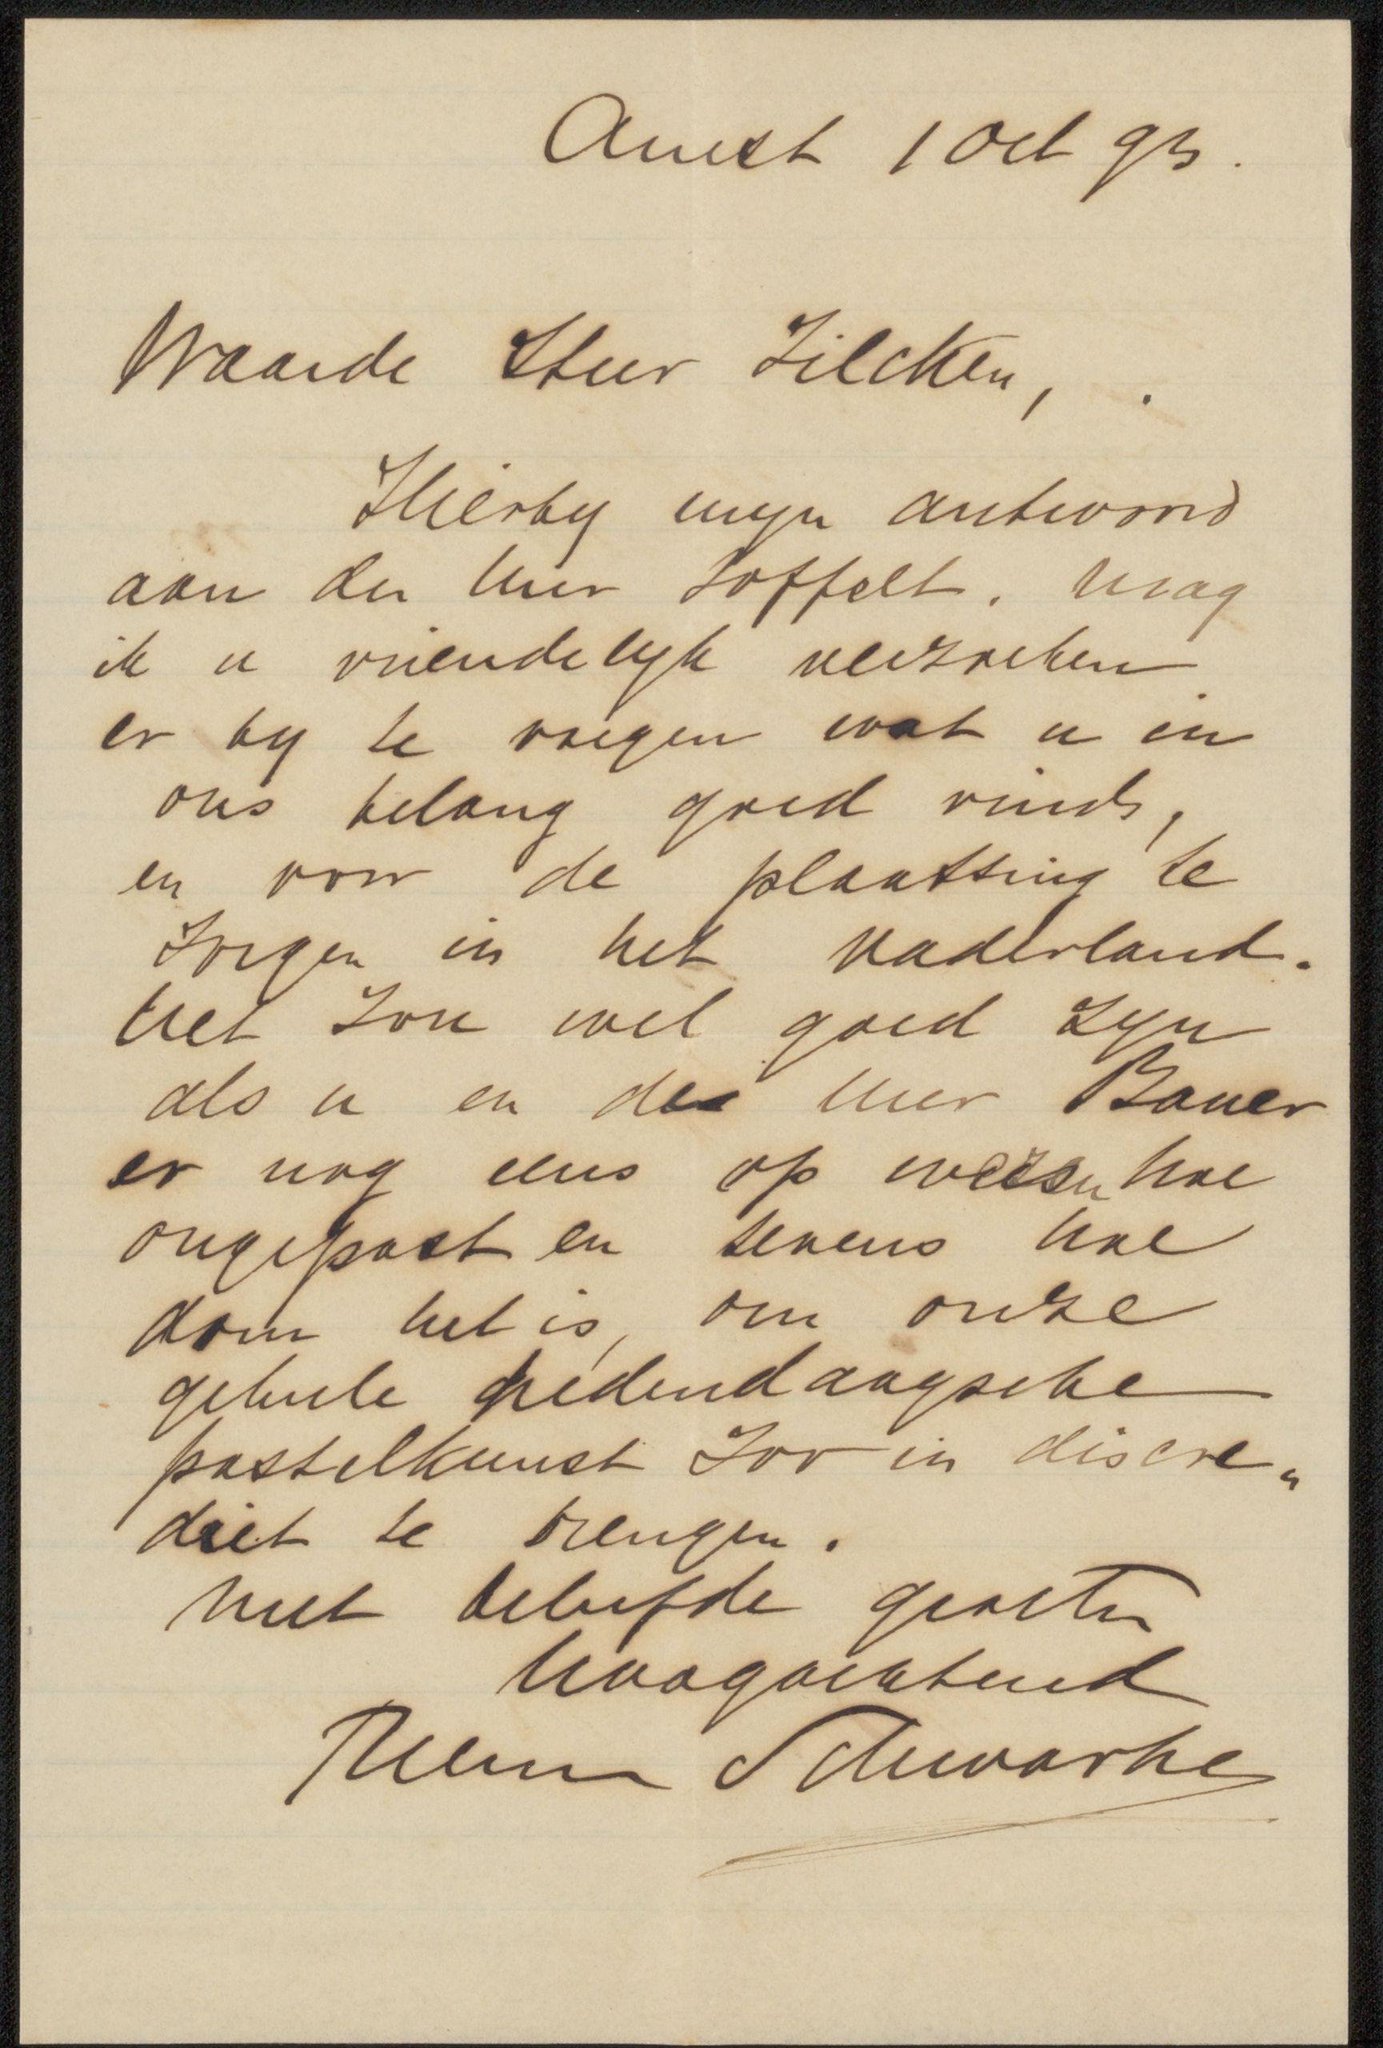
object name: letter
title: Brief aan Philip Zilcken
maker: thérèse schwartze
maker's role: draughtsman, painter, print maker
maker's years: 1851-1918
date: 1893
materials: ink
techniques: pen, writing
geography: amsterdam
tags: amsterdam, print maker, marius bauer, antonie cornelis loffelt, the hague, painter, draughtsman, philip zilcken, drawing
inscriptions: collector's mark: ‘RPK’